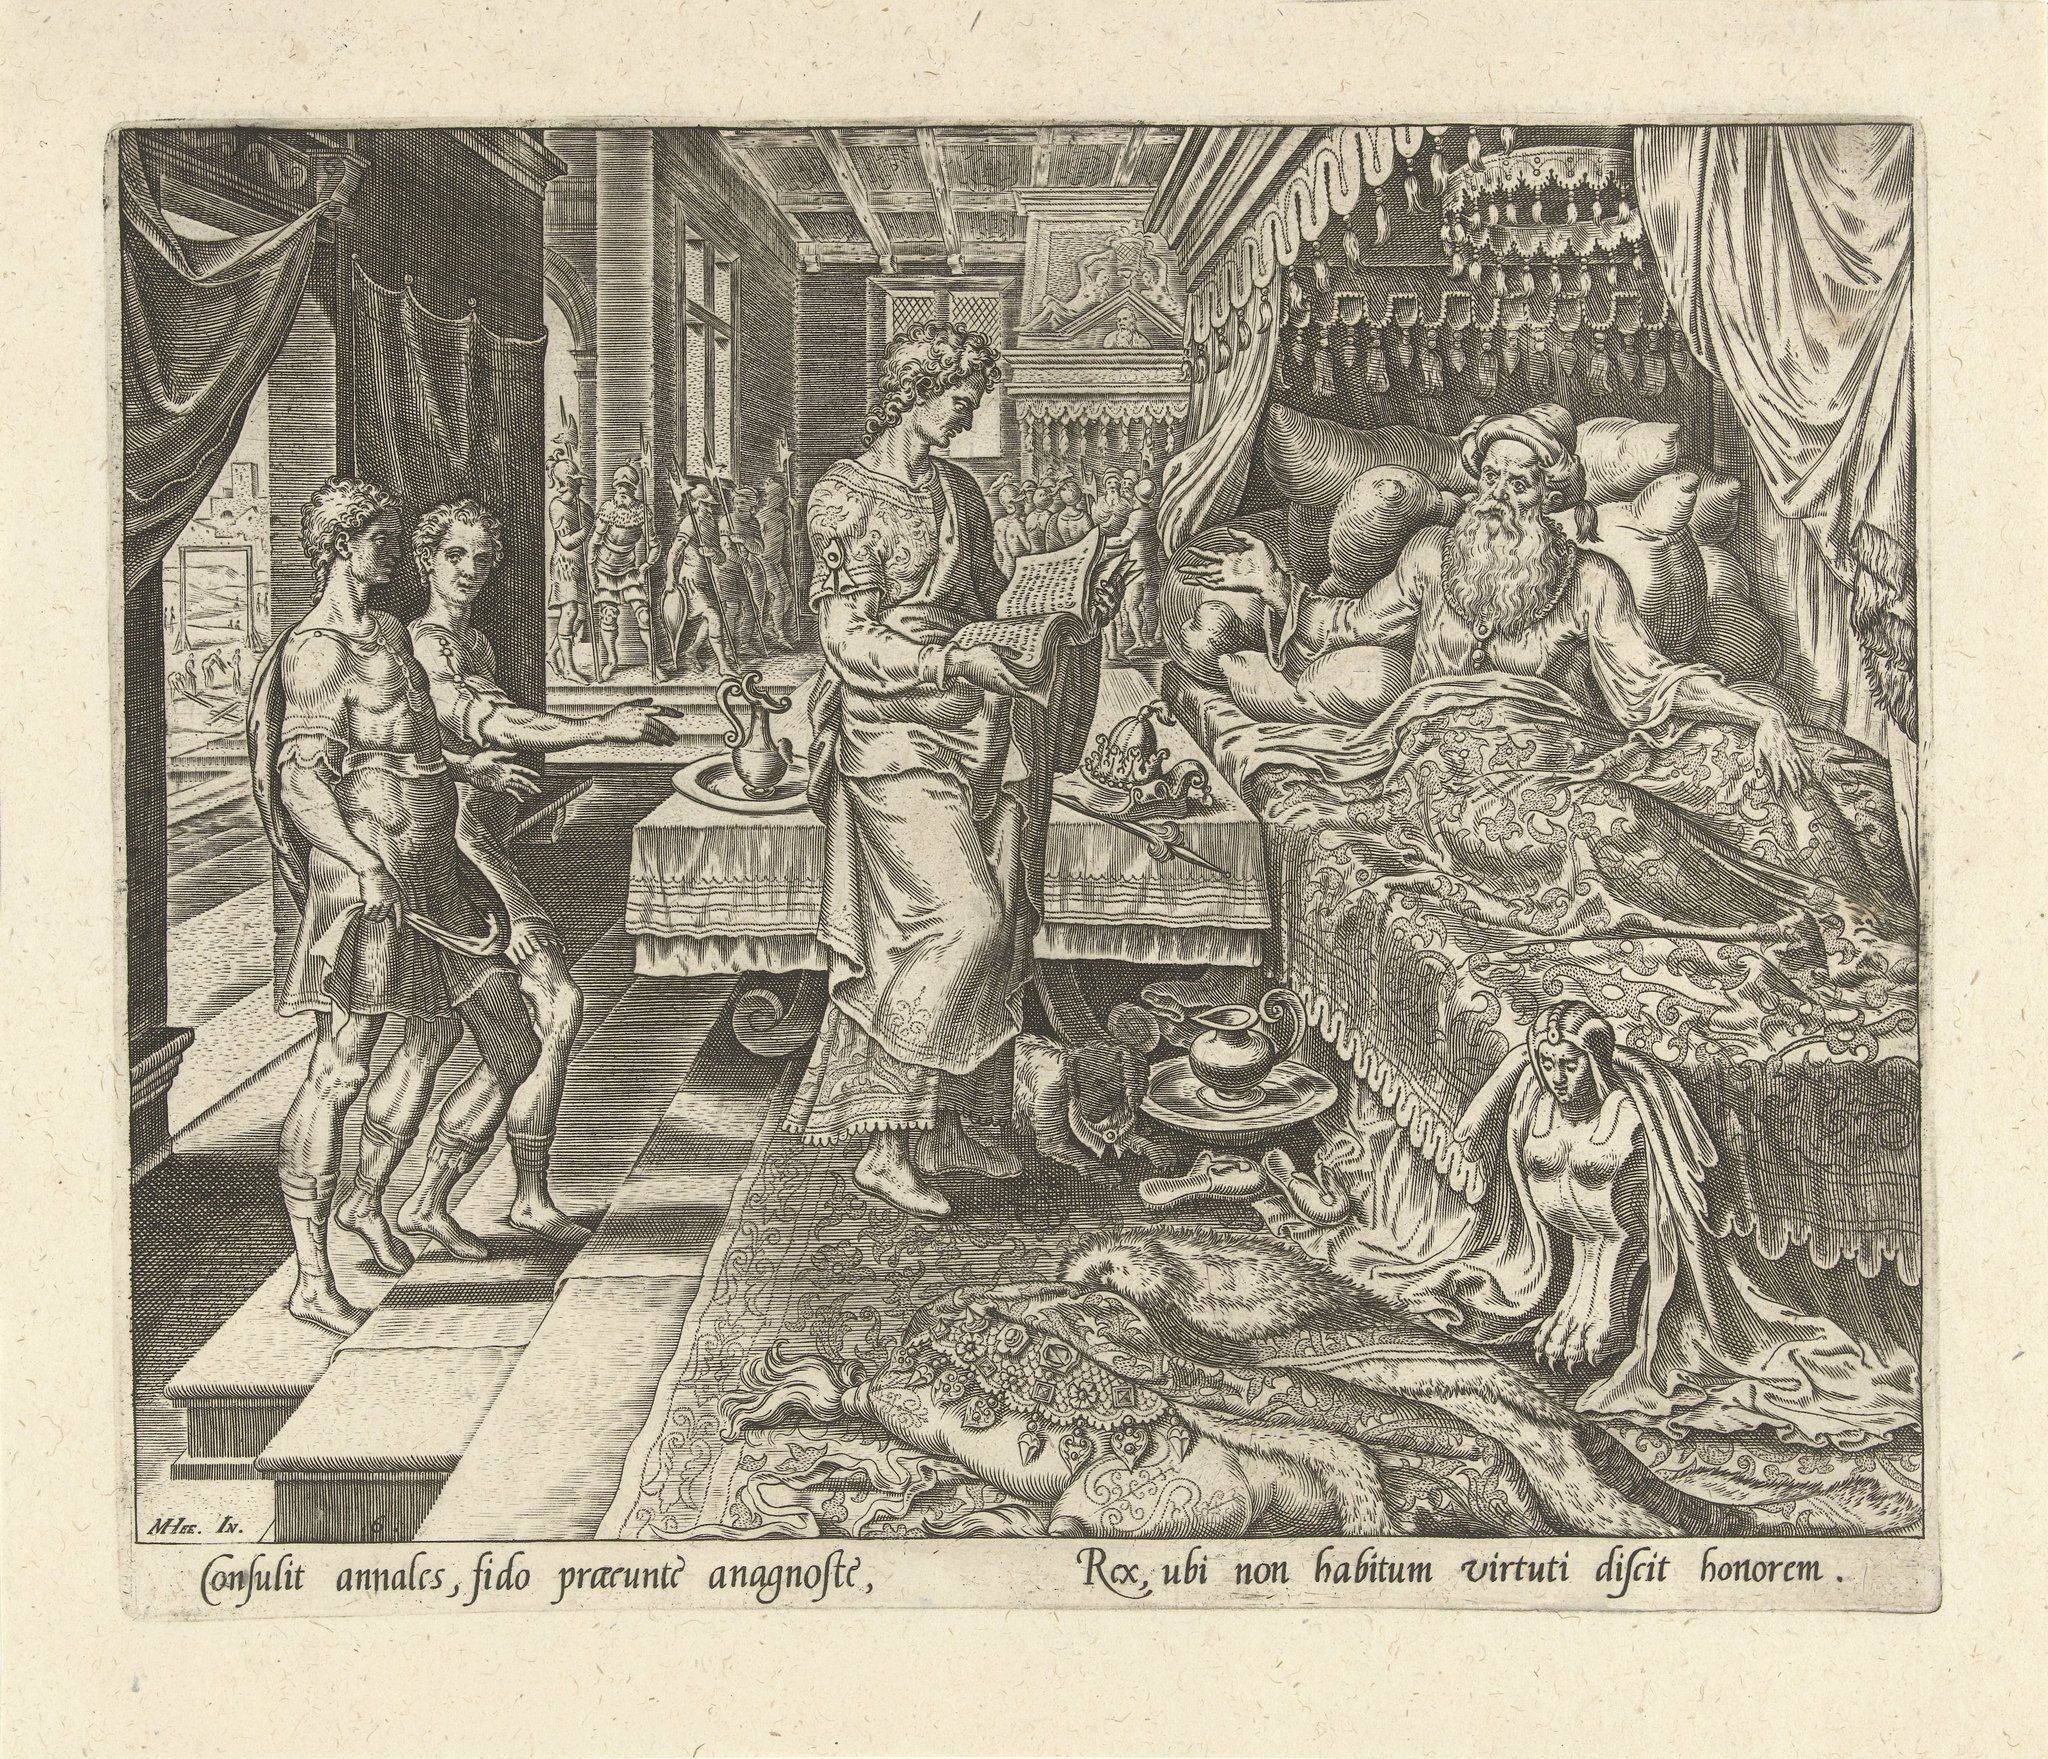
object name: print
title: Geschiedenis van Ester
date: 1564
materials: paper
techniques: engraving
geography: haarlem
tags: ahasuerus being sleepless, has the court records read to him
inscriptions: collector's mark: Lugt 2228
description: Ahasveros ligt op bed en omdat hij niet in slaap kan komen, laat hij zich voorlezen uit de kronieken. Door het gordijn is te zien hoe Haman buiten de galg voor Mordekai voorbereidt.